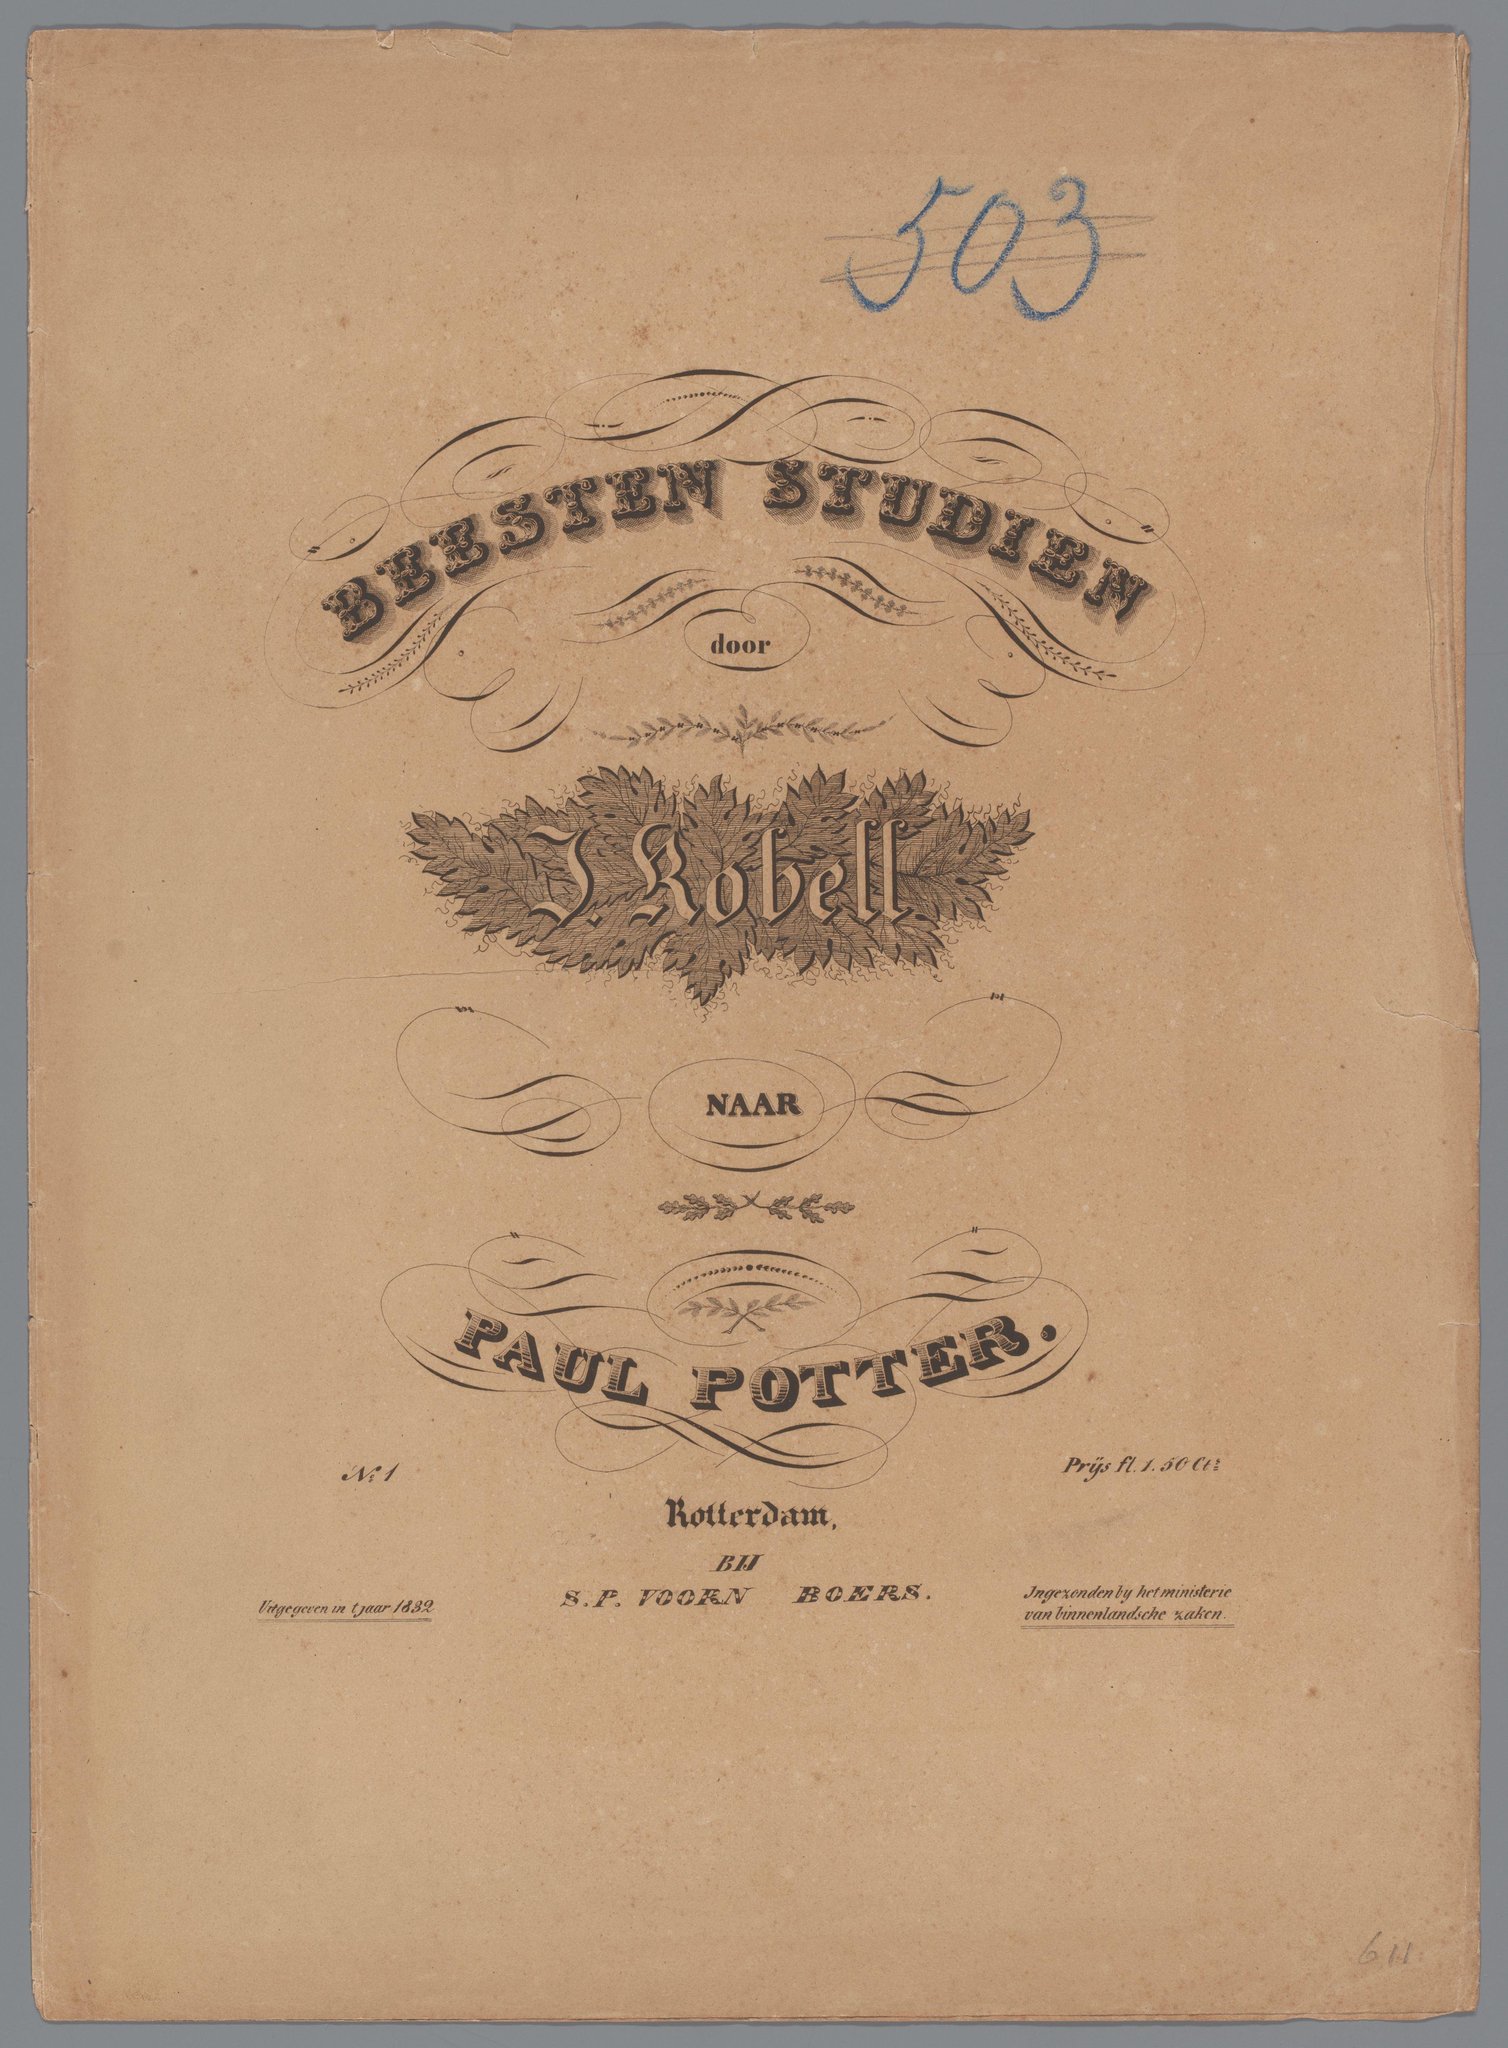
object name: print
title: Omslag voor: Beesten Studien door J. Kobell naar Paul Potter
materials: paper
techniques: lithograph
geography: rotterdam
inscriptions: date